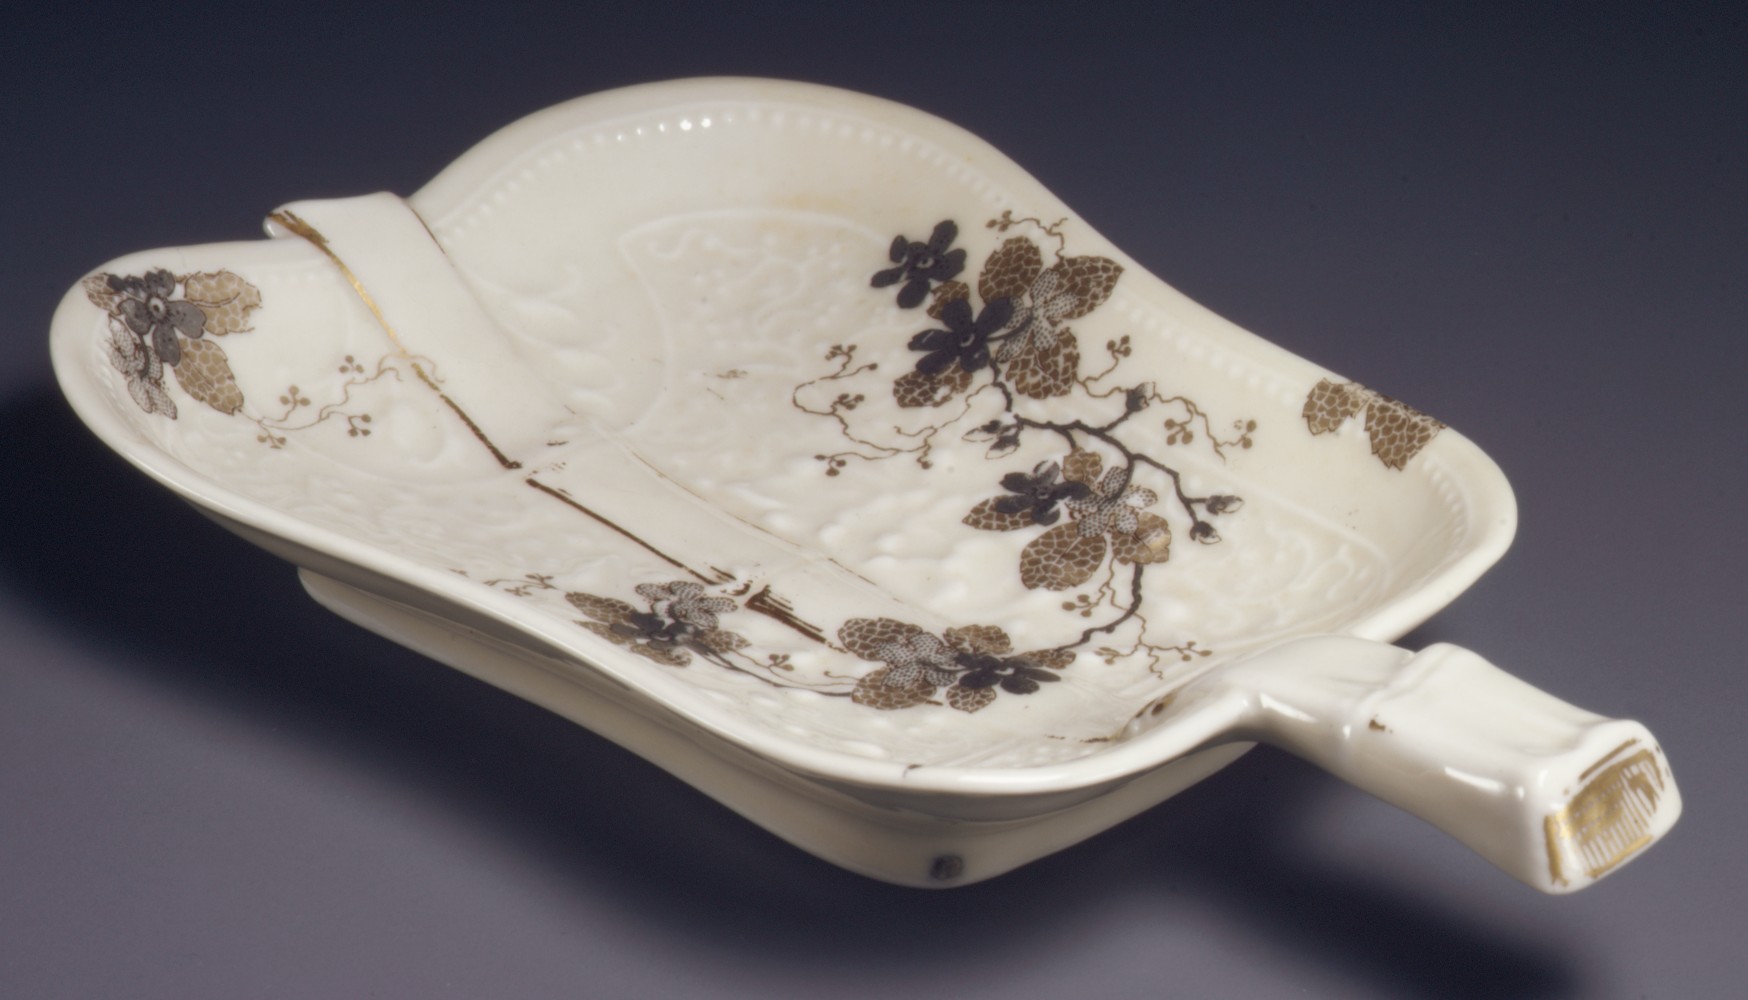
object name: dish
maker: edouard-alexandre dammouse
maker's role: modeler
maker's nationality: french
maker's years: 1850-1903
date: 1886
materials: hard paste porcelain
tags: flowers